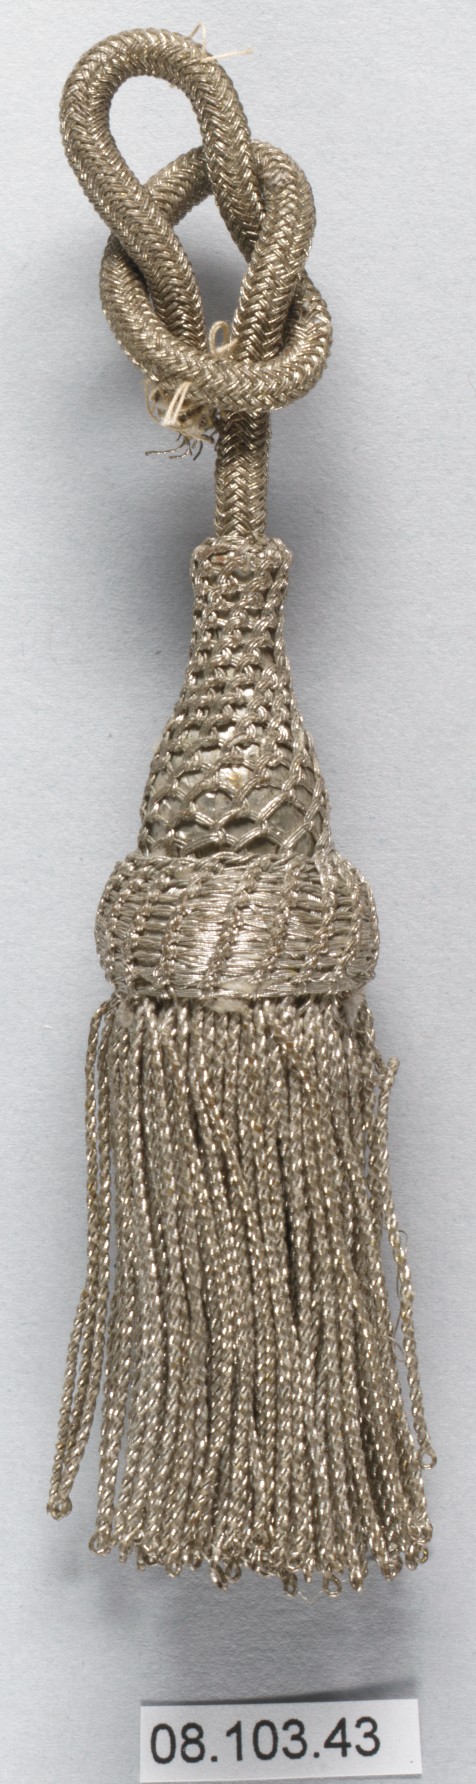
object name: tassel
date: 1701-1800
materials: metal thread